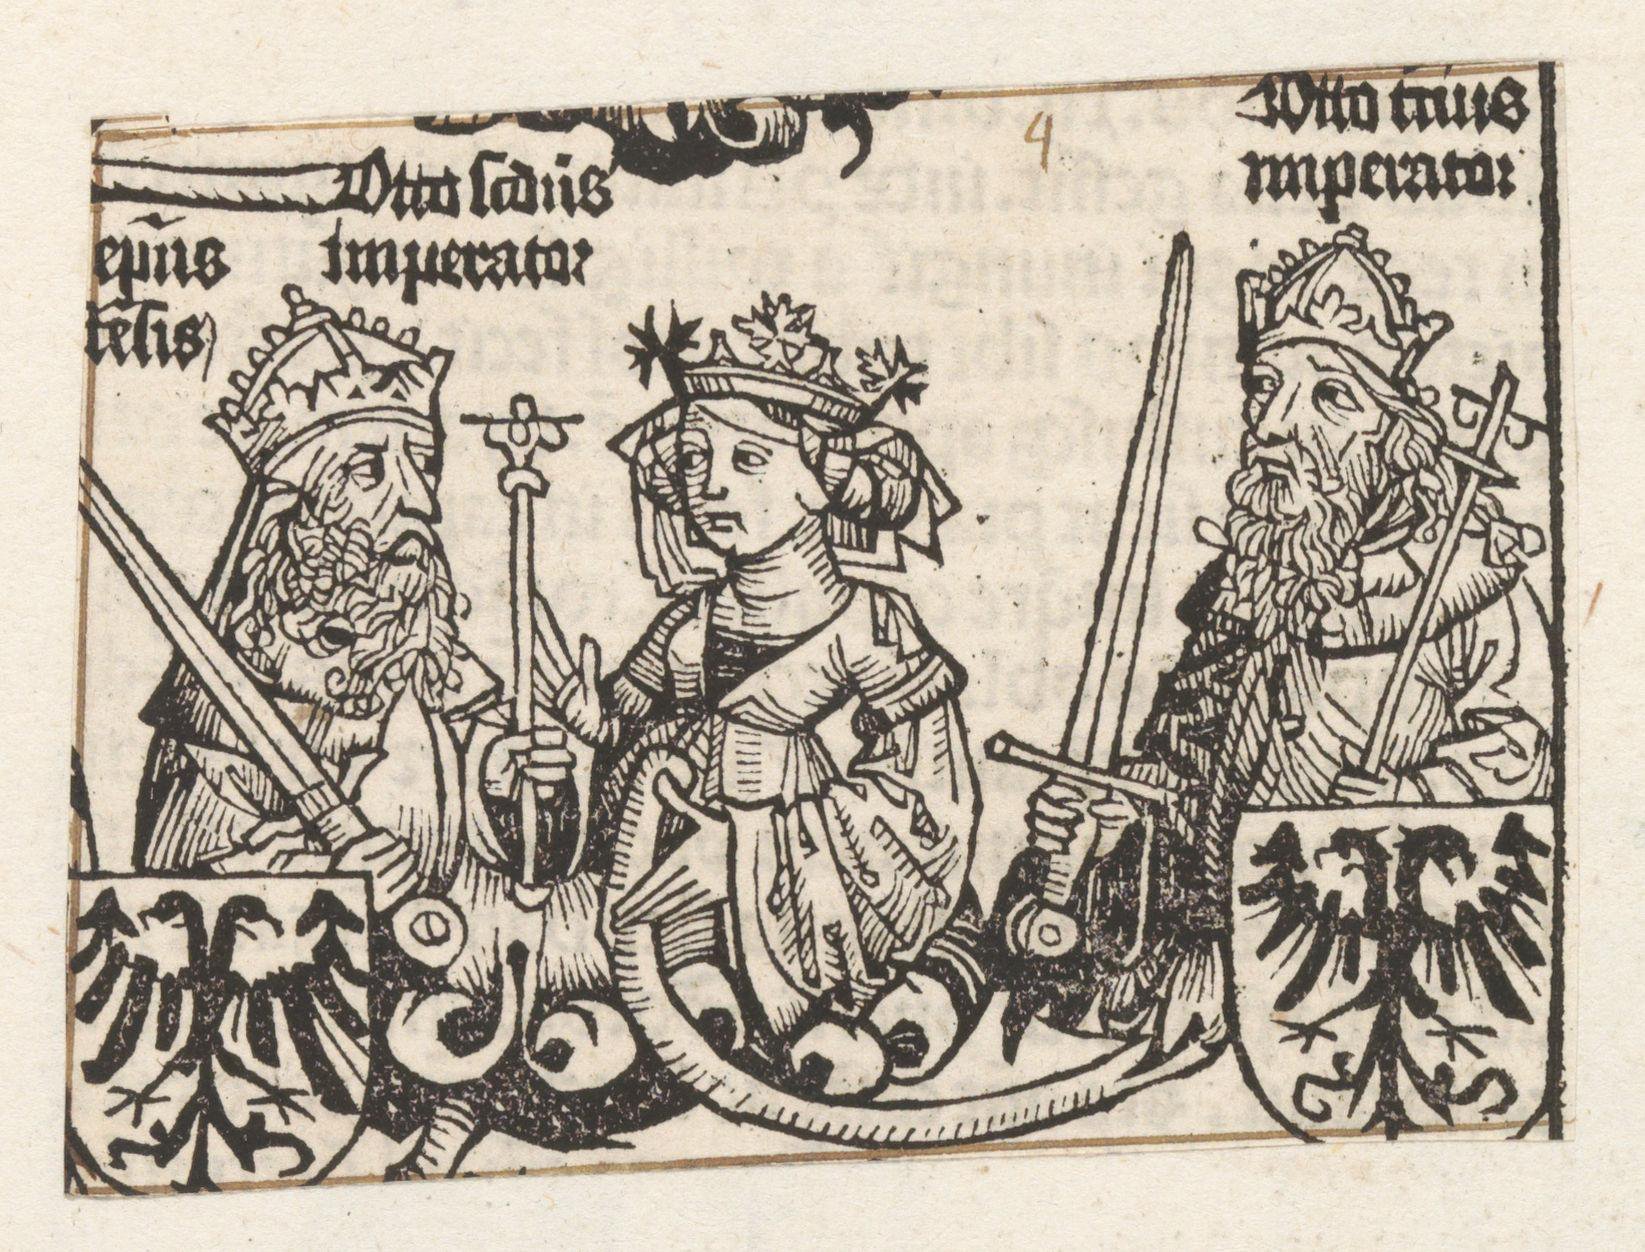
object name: album leaf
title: Otto se[cun]dus imperator / Otto t[er]cius imperator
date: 1493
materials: paper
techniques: letterpress printing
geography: nuremberg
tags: emperor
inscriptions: inscription: ‘4’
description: Bloemkelken met twee keizers en een keizerin. Ze dragen kronen en hebben zwaarden en scepters in hun handen. Daarbij twee wapenschilden met een dubbelkoppige adelaar. De voorstelling is onderdeel van de stamboom van keizer Hendrik II de Heilige in de Liber Chronicarum. De tekst identificeert de personen als keizer Otto II en zijn vrouw. Daarnaast zijn zoon keizer Otto III. De prent maakt deel uit van een album.